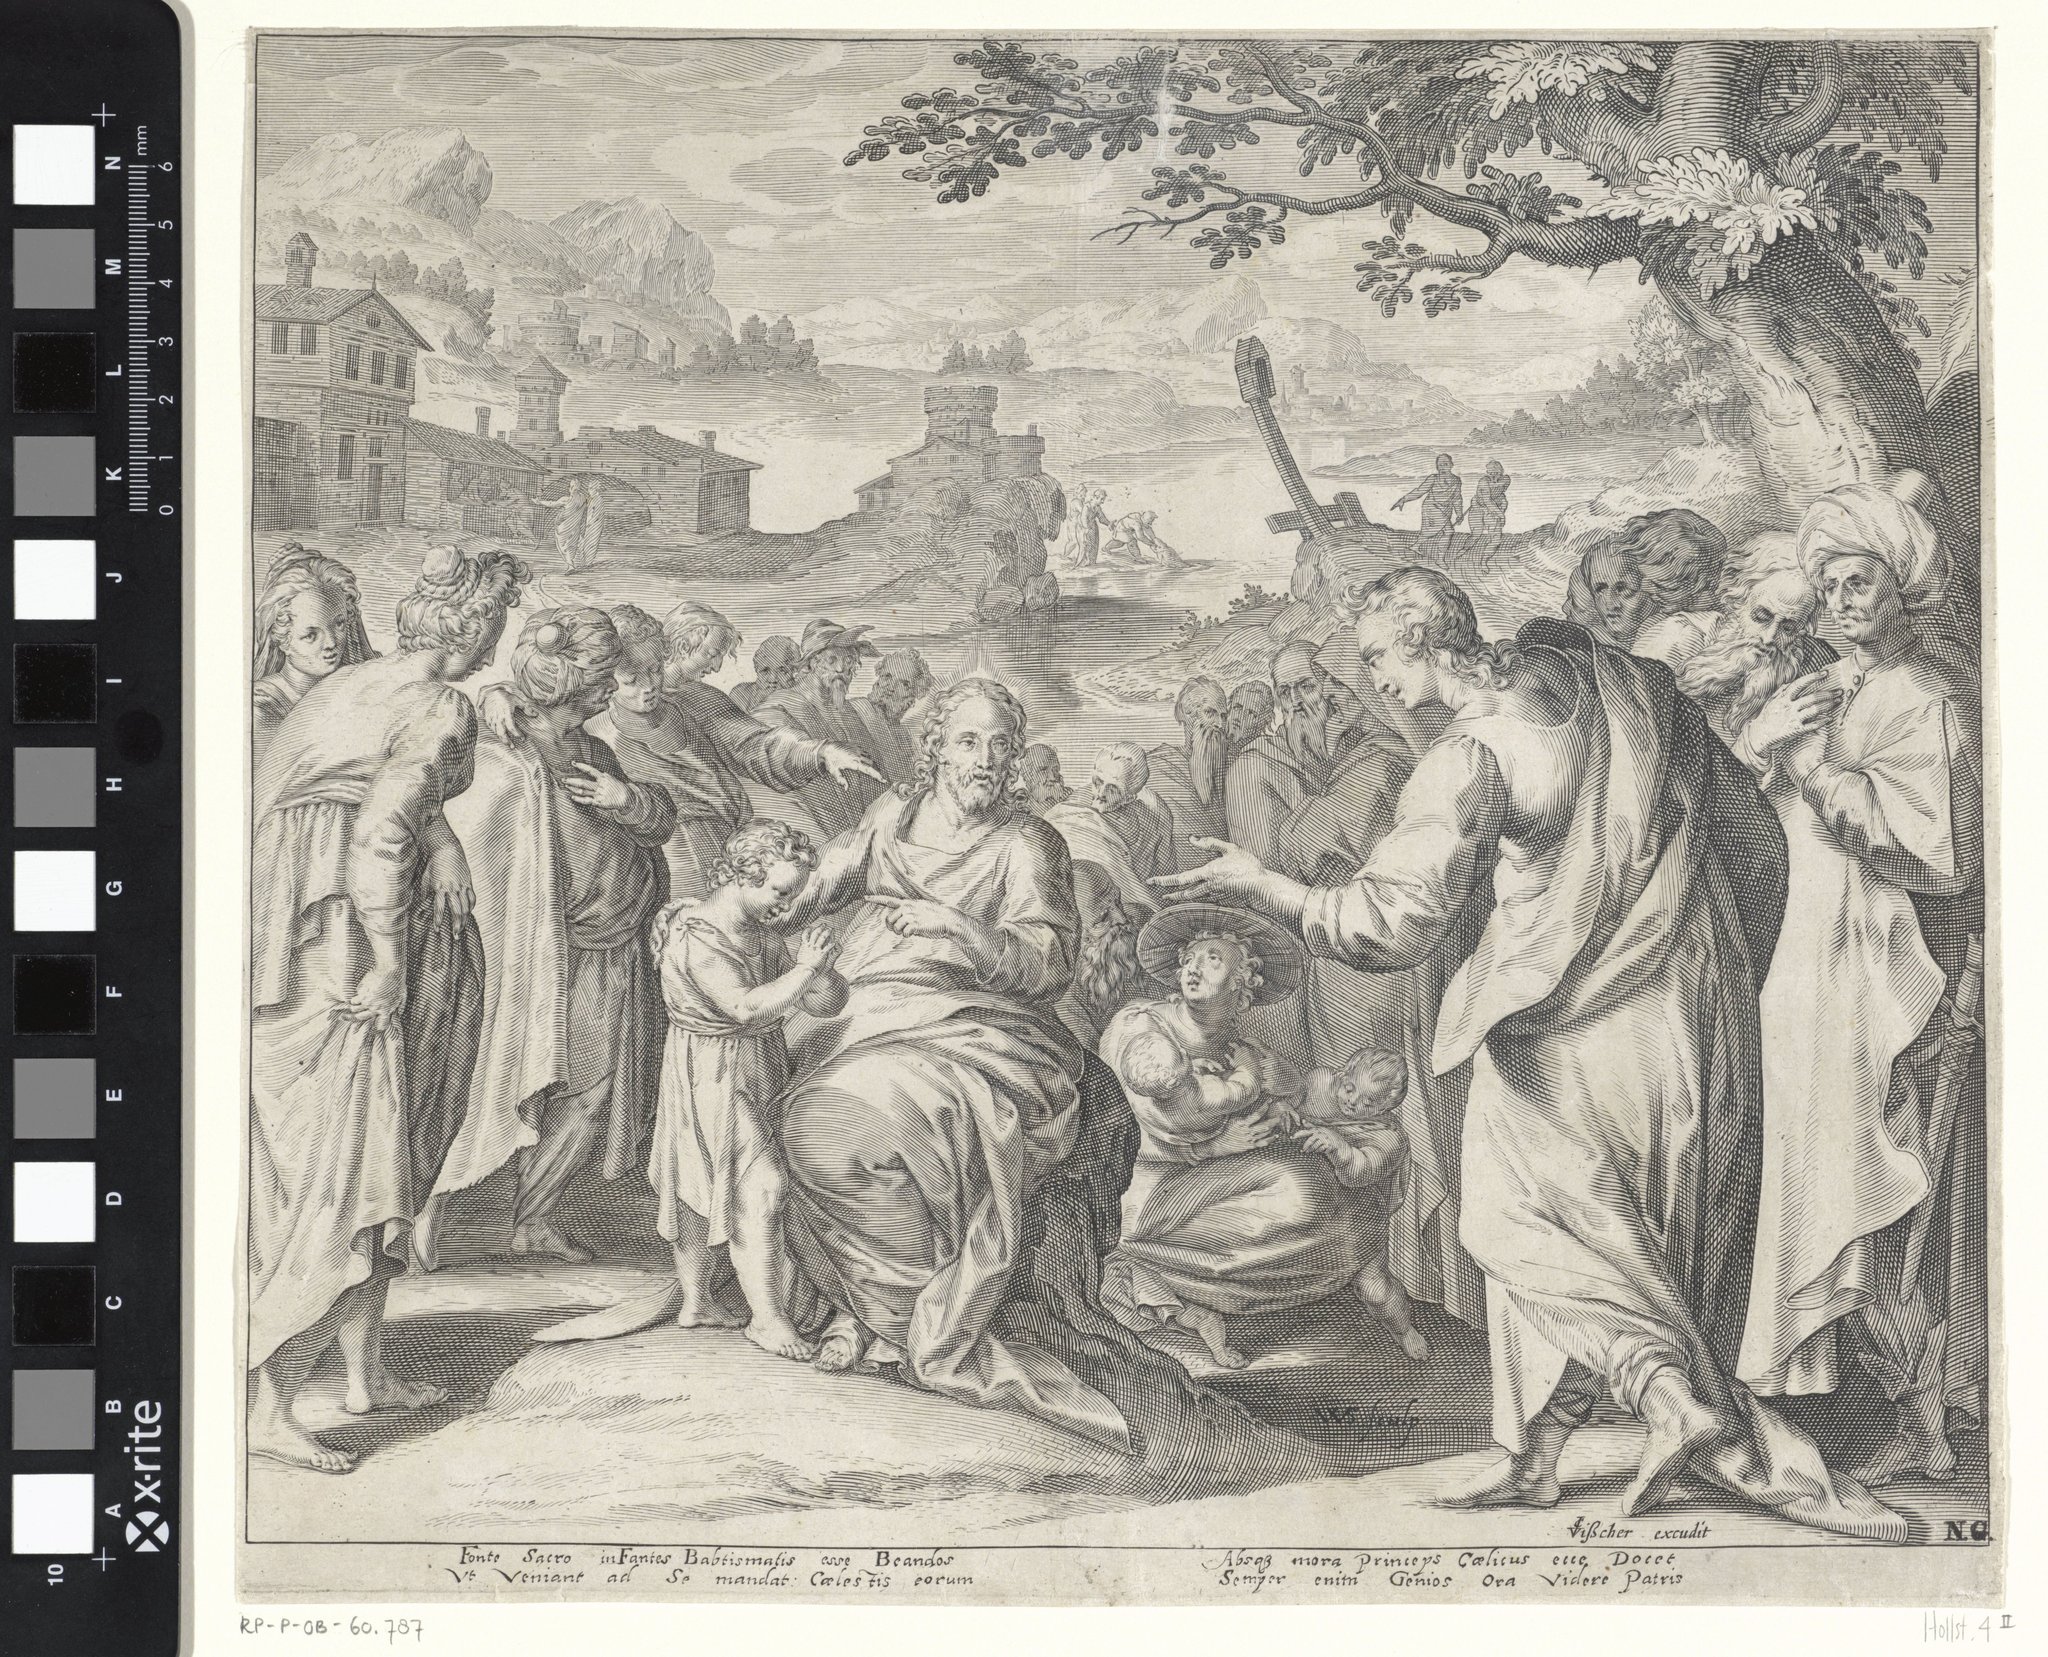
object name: print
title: Christus zegent de kinderen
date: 1601-1652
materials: paper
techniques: engraving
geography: leiden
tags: christ blessing children brought by their mothers, usually with some disciples disapprovingly looking on (matthew 19:13-15; mark 10:13-16; luke 18:15-17)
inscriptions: collector's mark: Lugt 1967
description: Christus zit te midden van een groep mensen, onder wie enkelen van zijn leerlingen en een paar moeders. Naast hem zit een moeder met twee kinderen. Hij heeft zijn arm om een jongen met gevouwen handen geslagen en spreekt tot de leerling die voor hem staat. In de verte staan enkele huizen. Onder de voorstelling bevindt zich een vierregelige, Latijnse tekst met een beschrijving van wat Christus in de scène zegt.